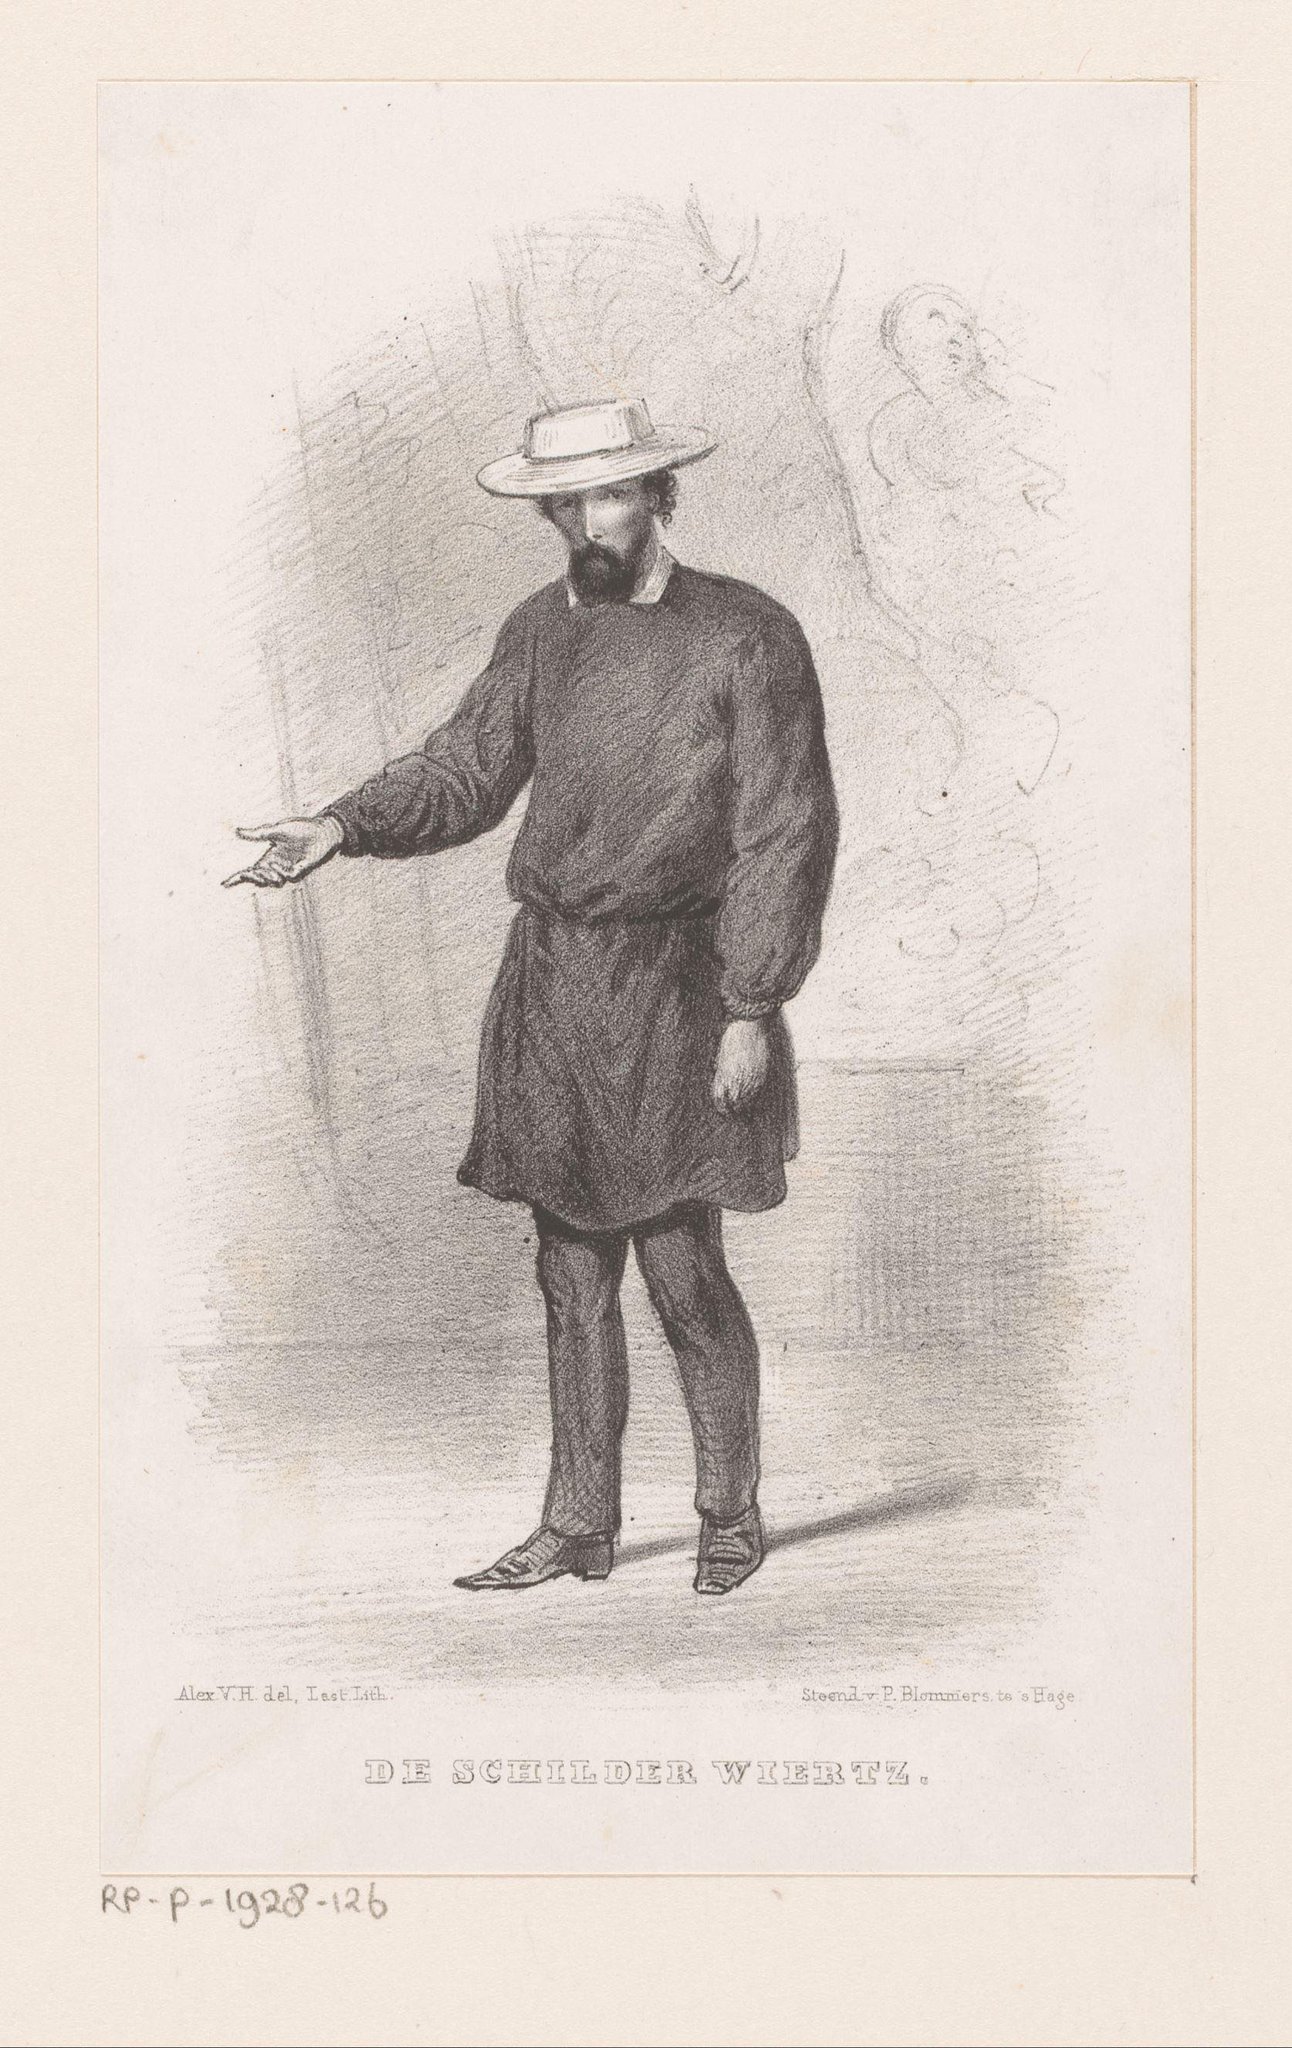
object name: print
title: Portret van Antoine Wiertz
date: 1842-1887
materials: paper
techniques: lithograph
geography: the hague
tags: brussels, draughtsman, antoine joseph wiertz, portrait, self-portrait of painter, historical persons (+ full length portrait)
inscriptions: collector's mark: Lugt 2228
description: De geportretteerde staat voor een groot schilderij.